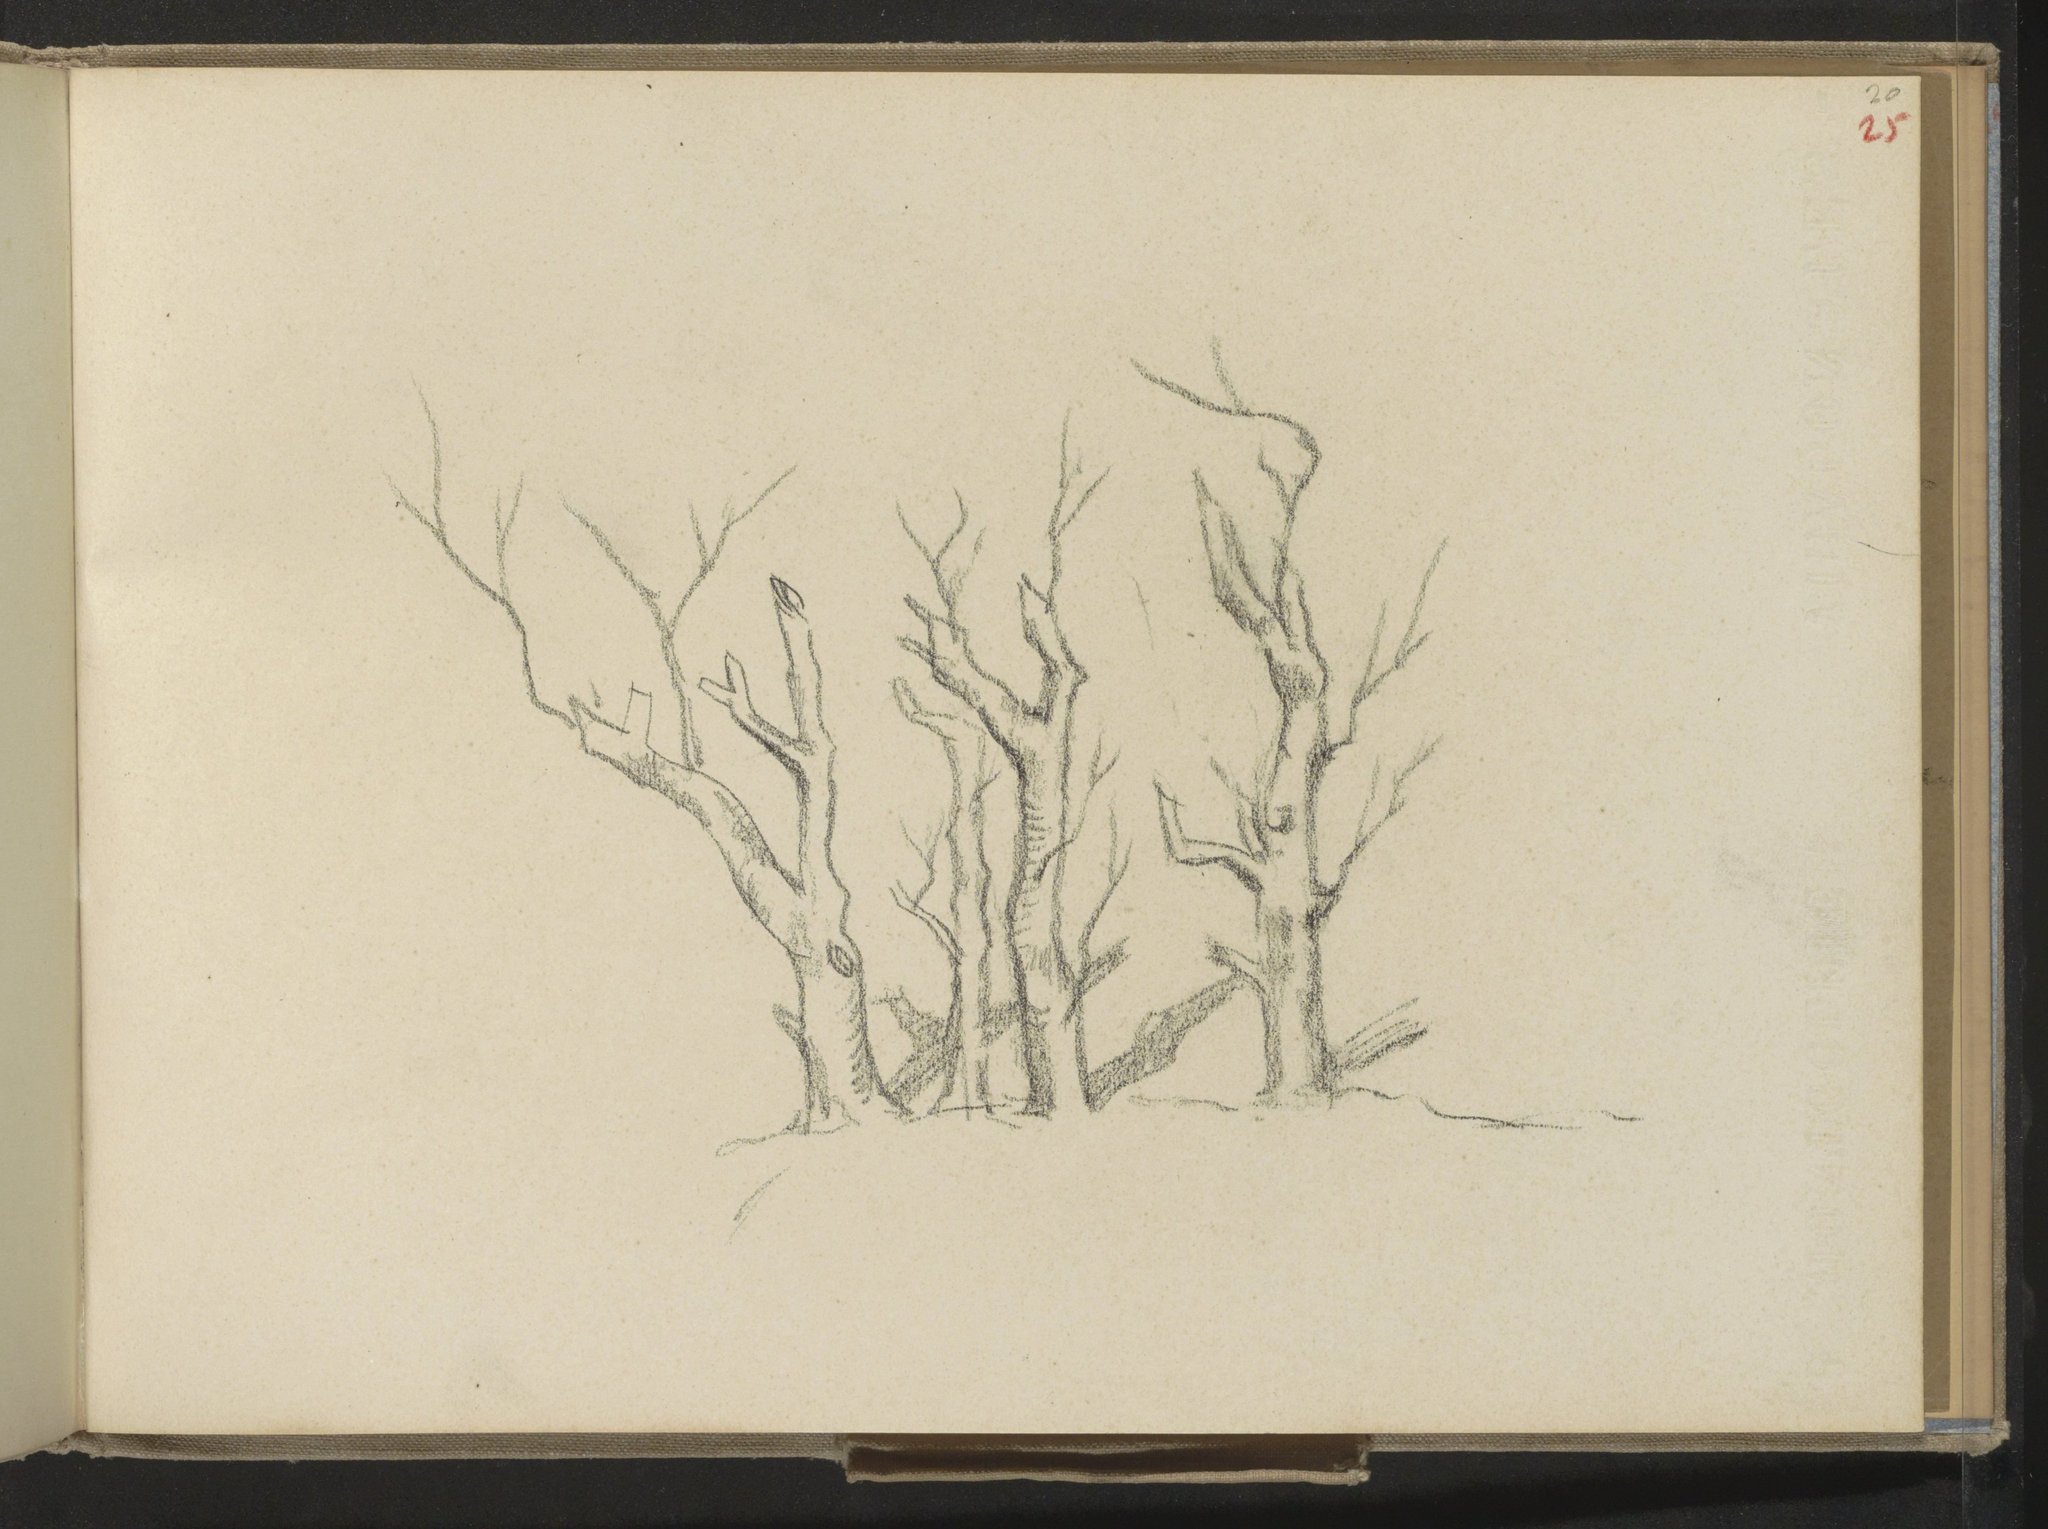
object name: sketchbook leaf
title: Bomen met kale takken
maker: jozef israëls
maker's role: draughtsman, painter, print maker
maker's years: 1824-1911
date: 1834-1911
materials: chalk, paper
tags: trees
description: Blad 20 recto uit een schetsboek met 27 bladen.